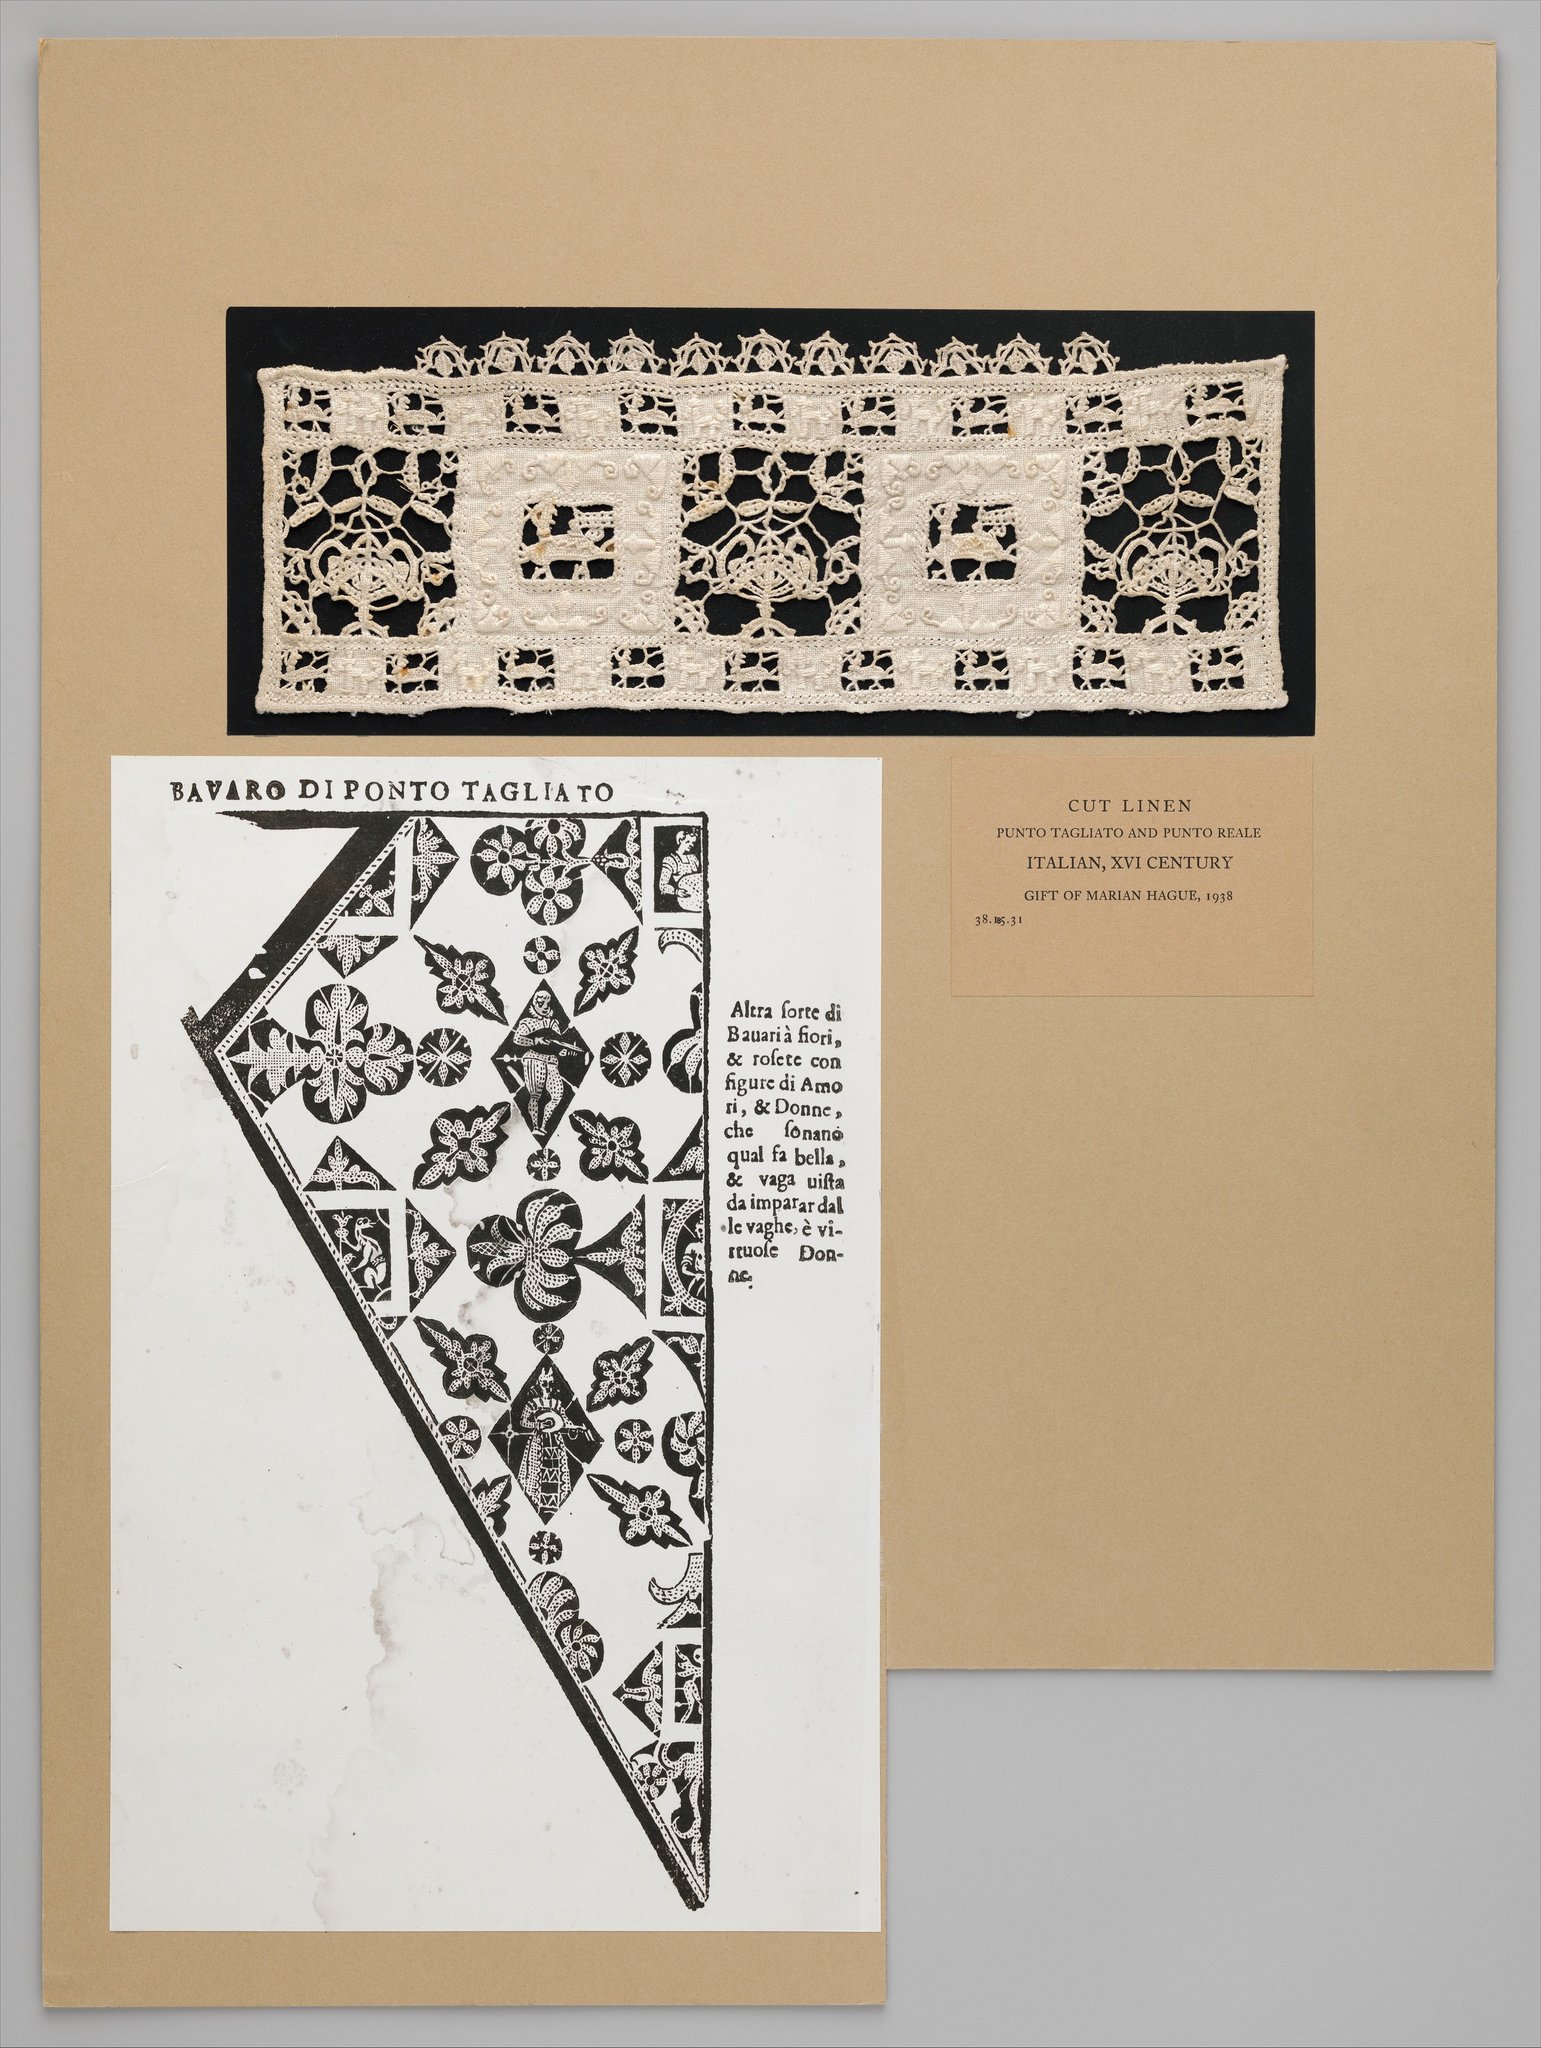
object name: piece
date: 1501-1600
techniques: embroidery